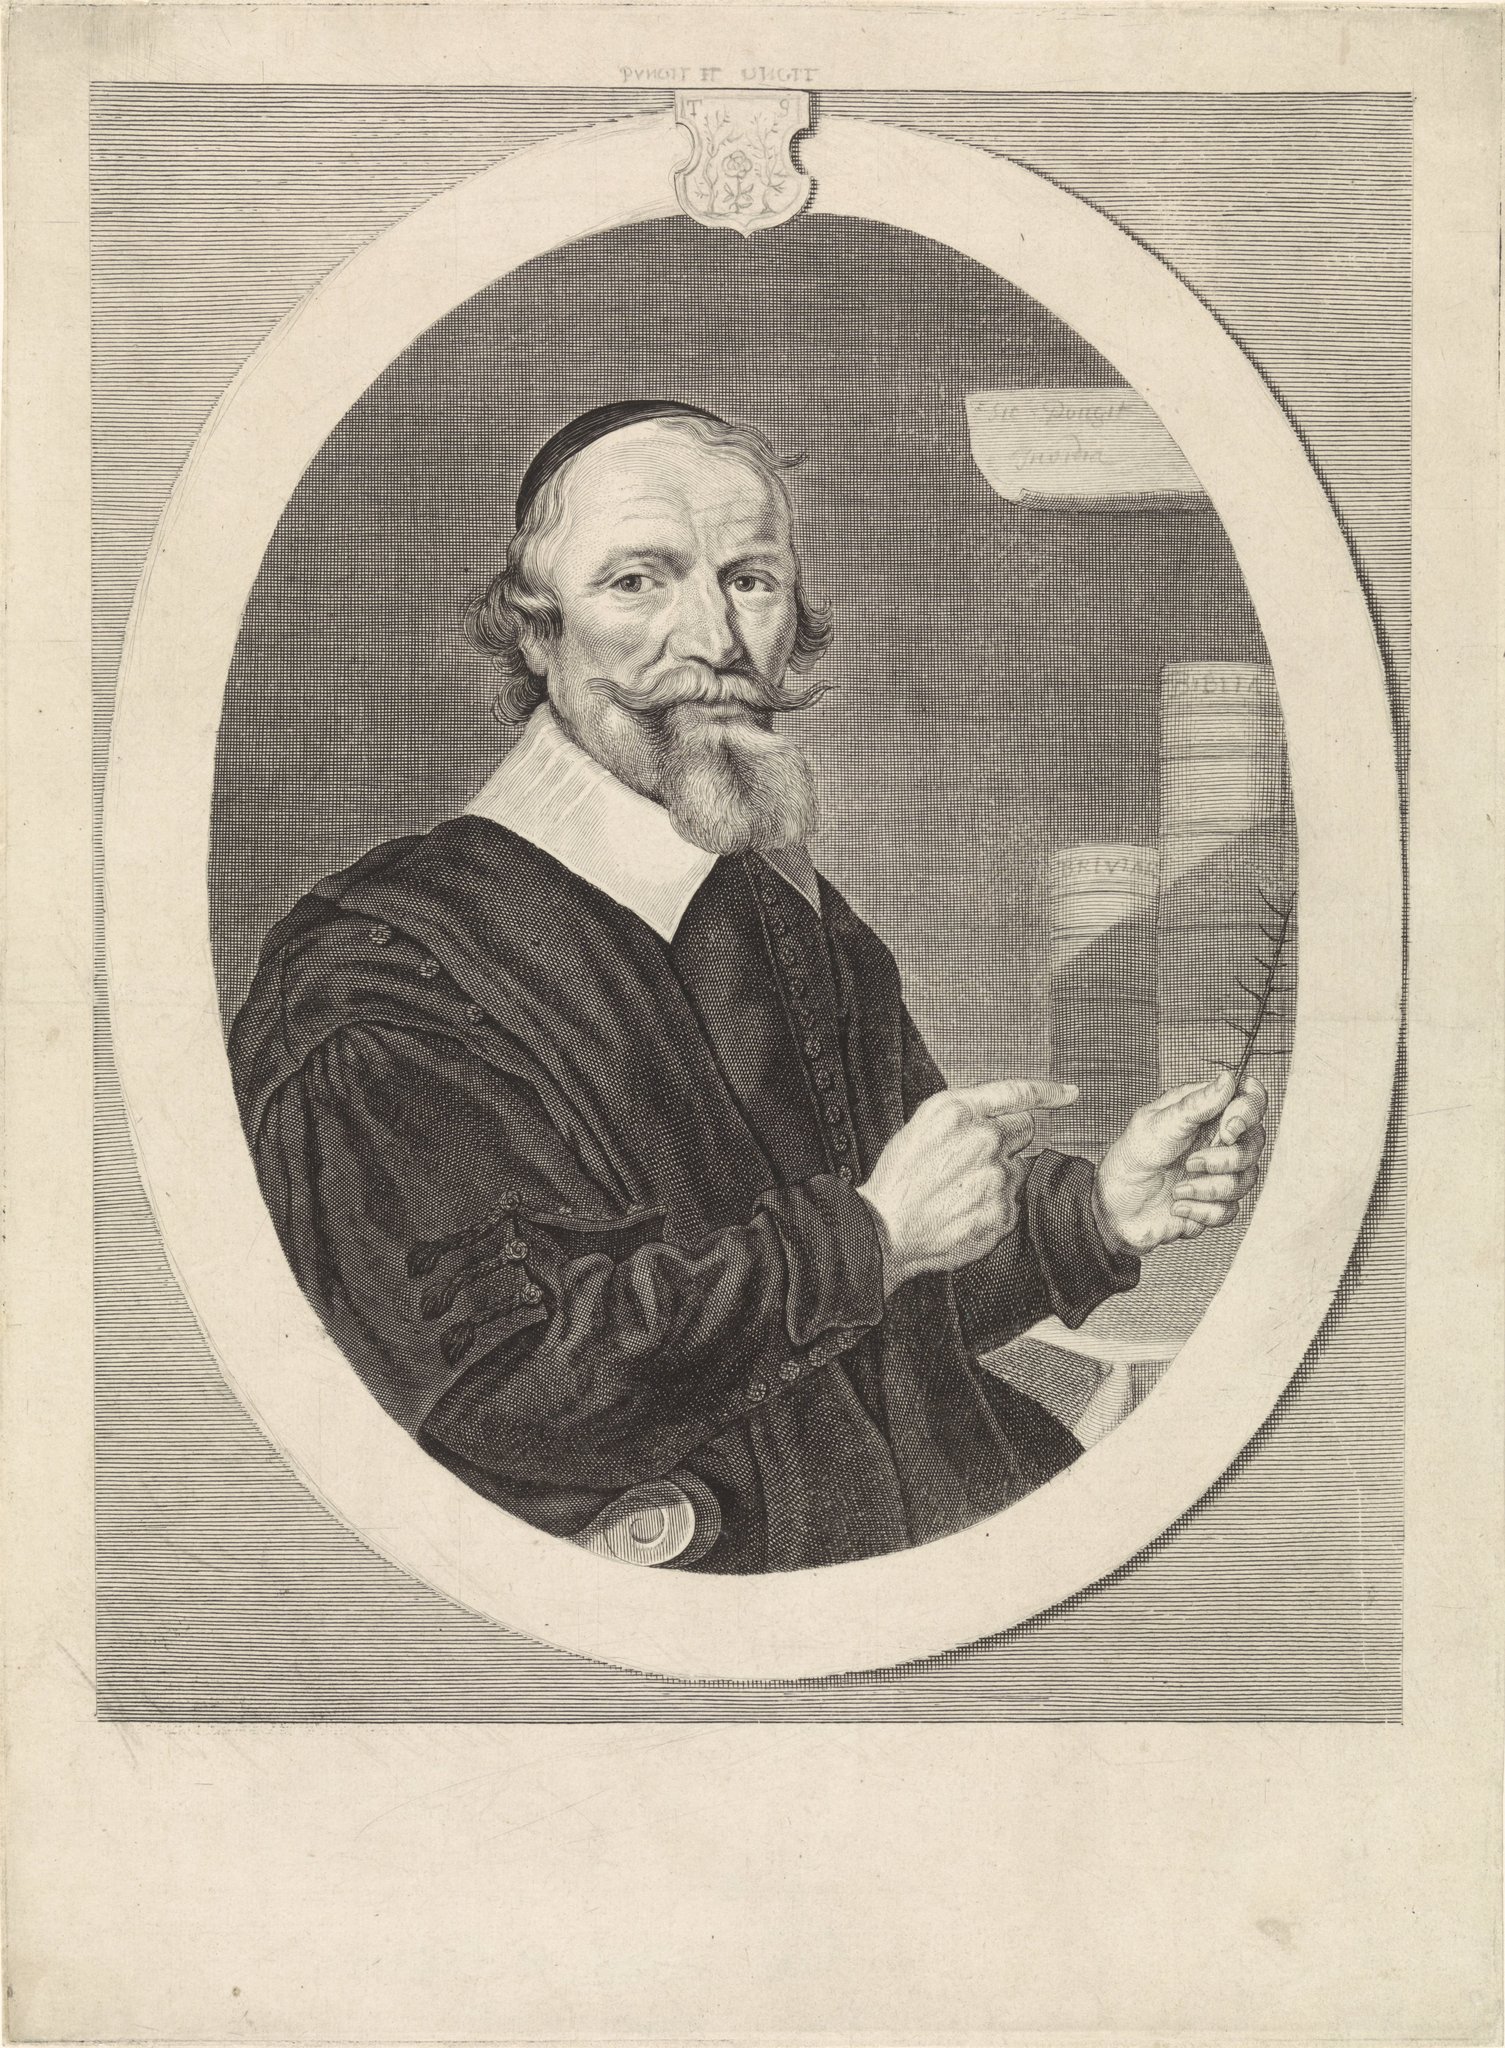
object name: print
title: Portret van Timotheus de Sayer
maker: theodor matham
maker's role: draughtsman, print maker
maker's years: 1605-1676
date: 1658-1676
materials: paper, pencil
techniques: engraving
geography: northern netherlands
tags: timotheus de sayer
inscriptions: collector's mark: Lugt 2228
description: Portret van Timotheus de Sayer, pastoor in het Gooiland.